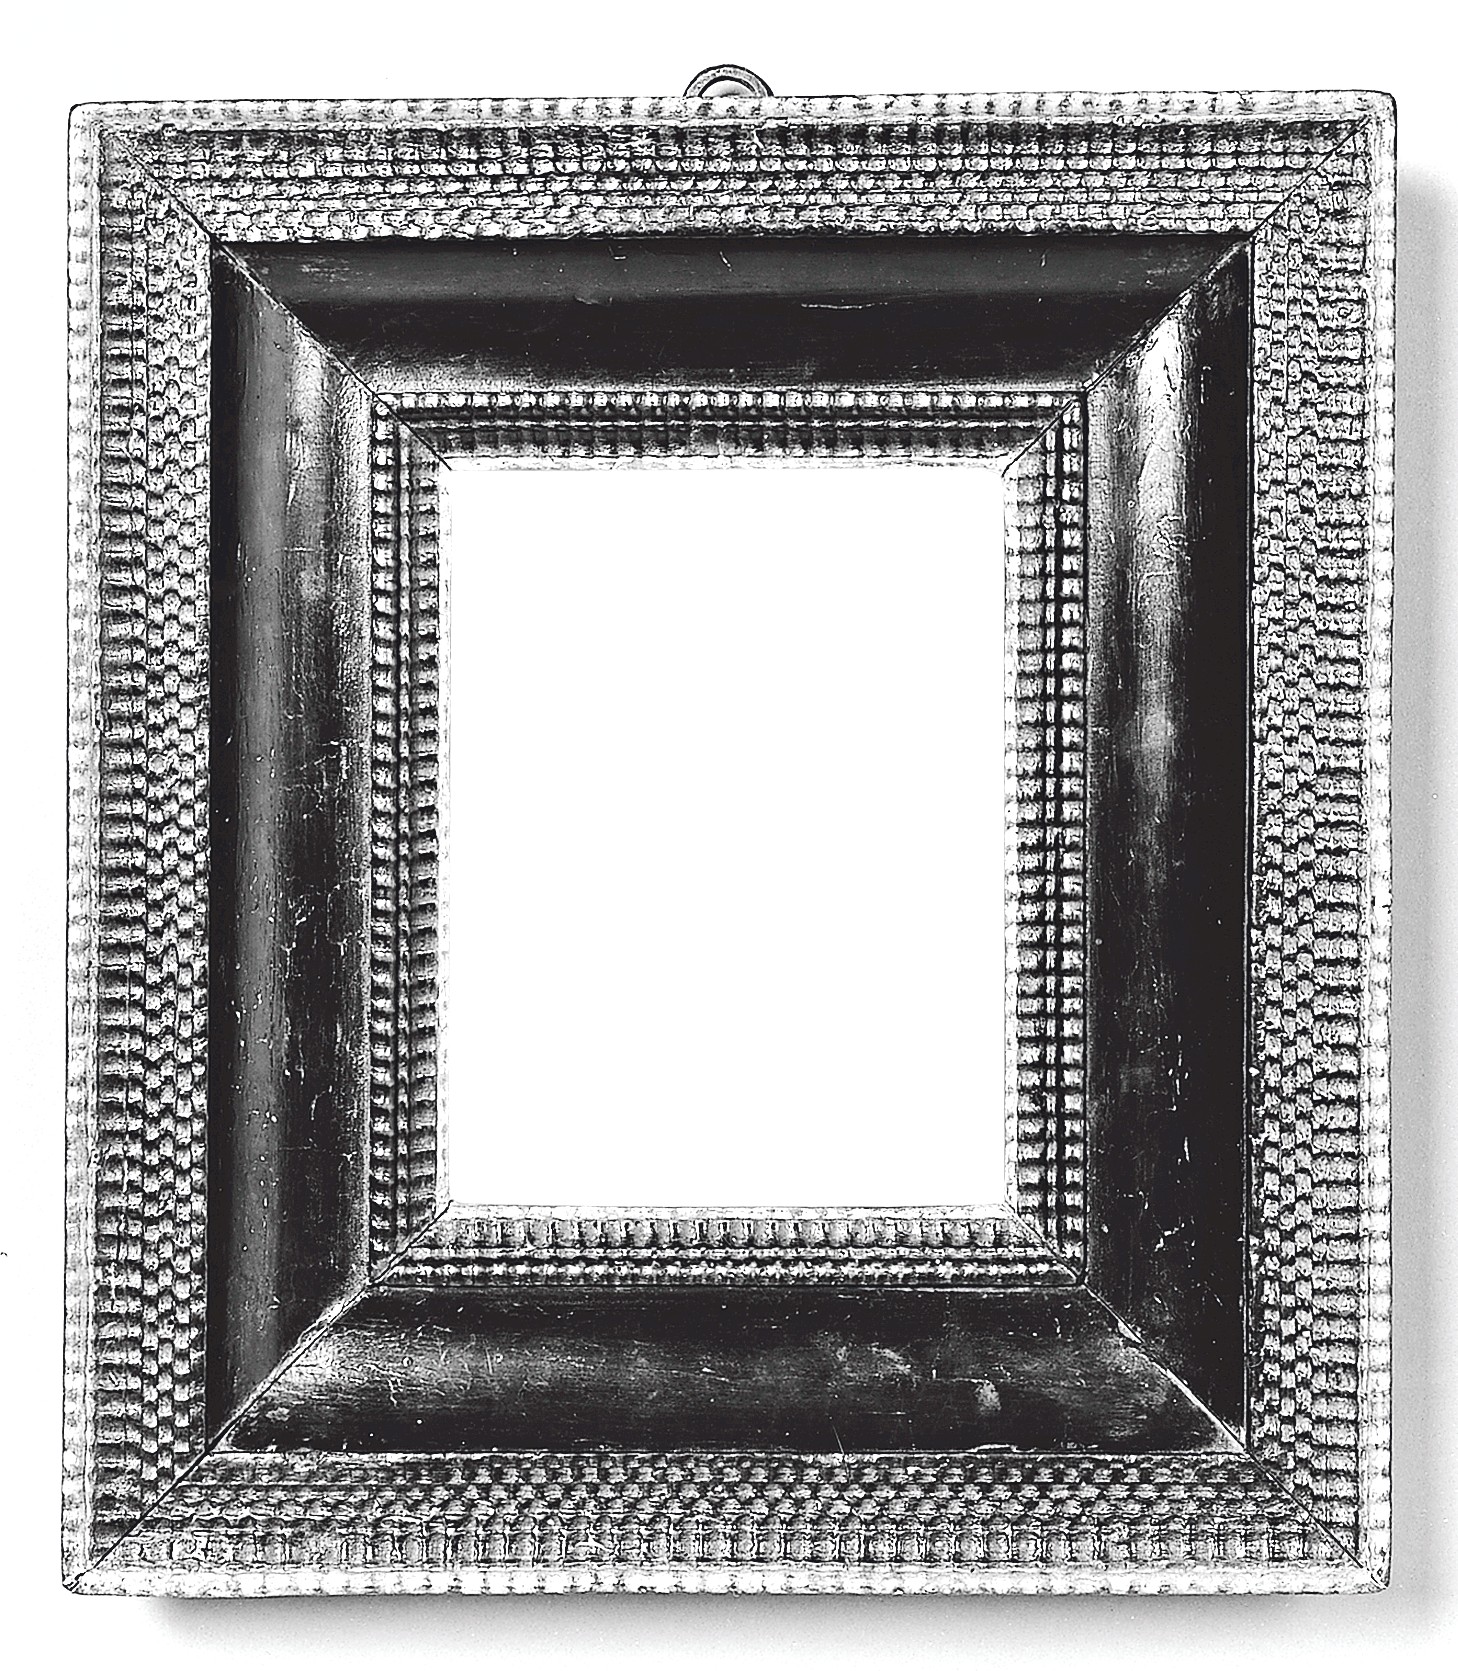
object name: frame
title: Ripple frame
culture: german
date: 1601-1633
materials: wood